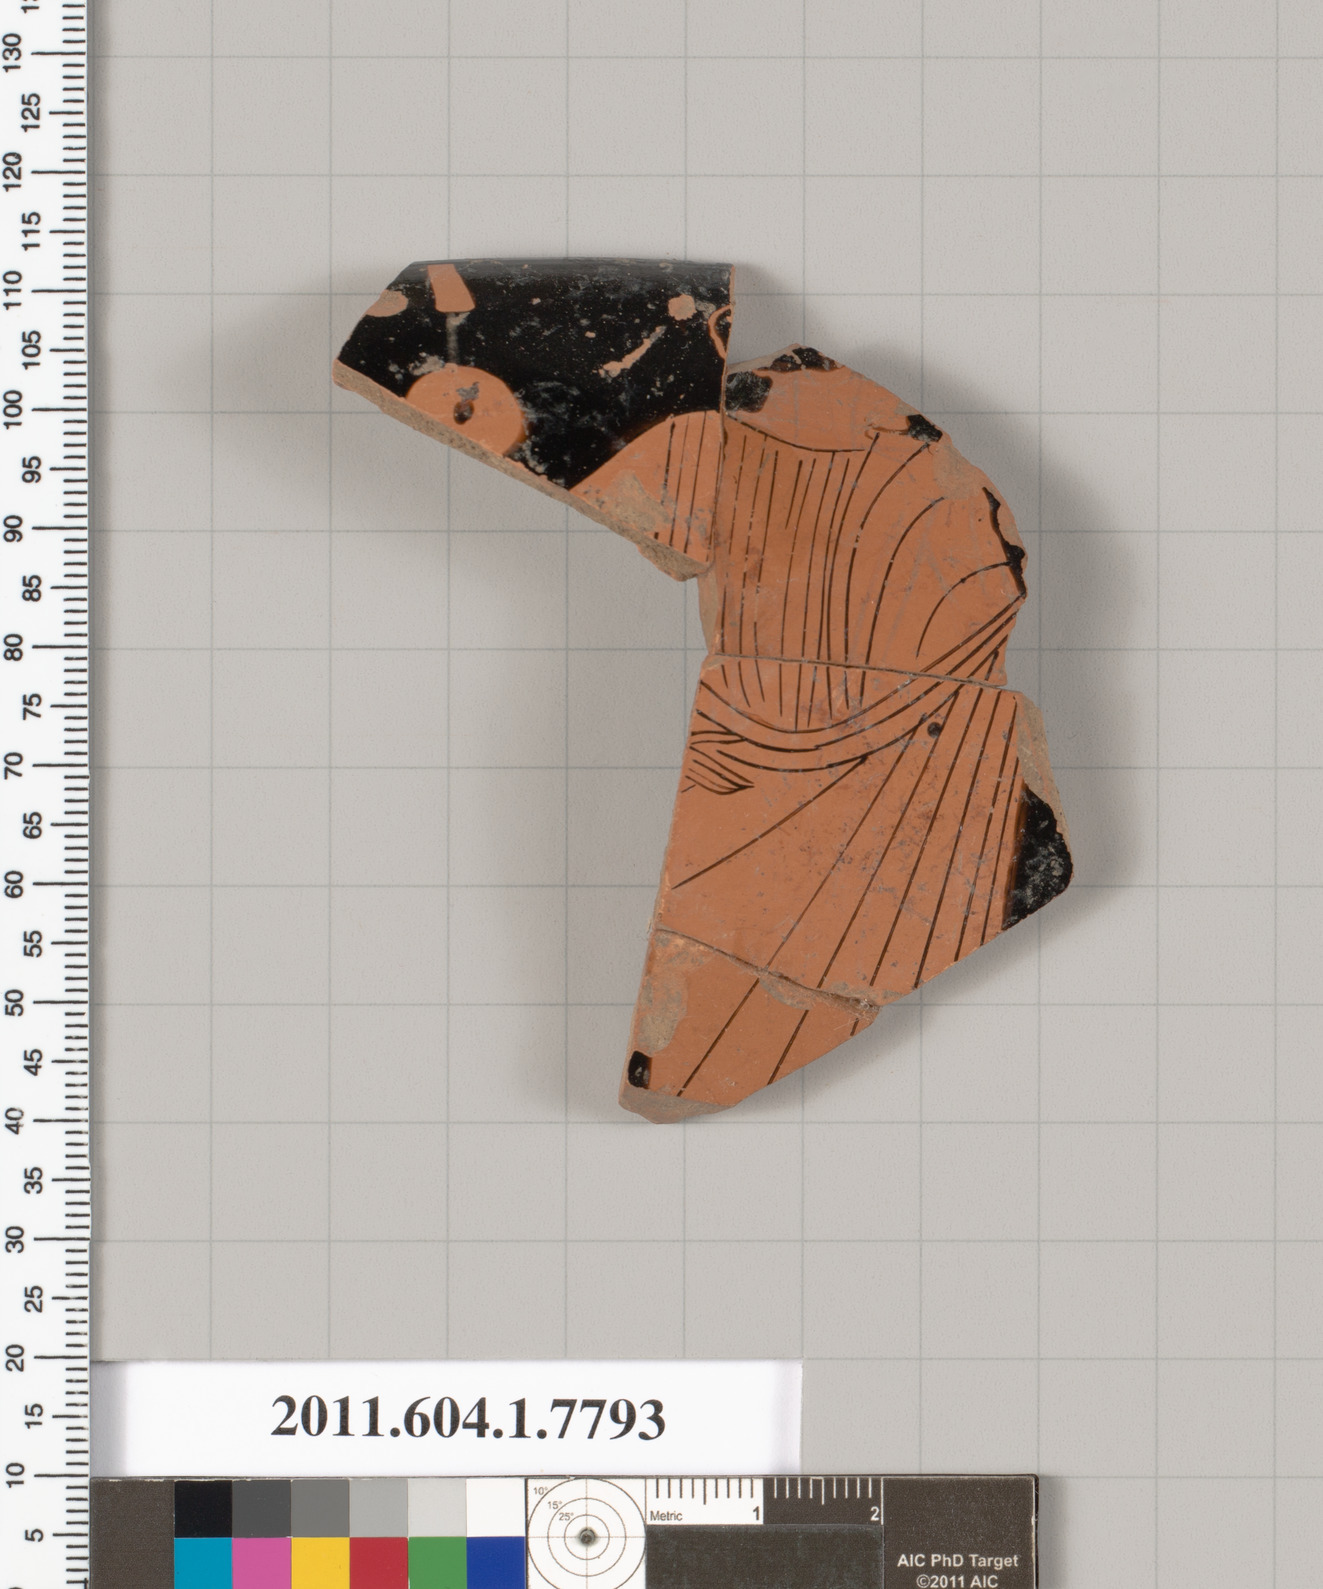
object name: kylix fragment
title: Terracotta rim fragment of a kylix (drinking cup)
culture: greek, attic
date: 460-450 BCE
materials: terracotta